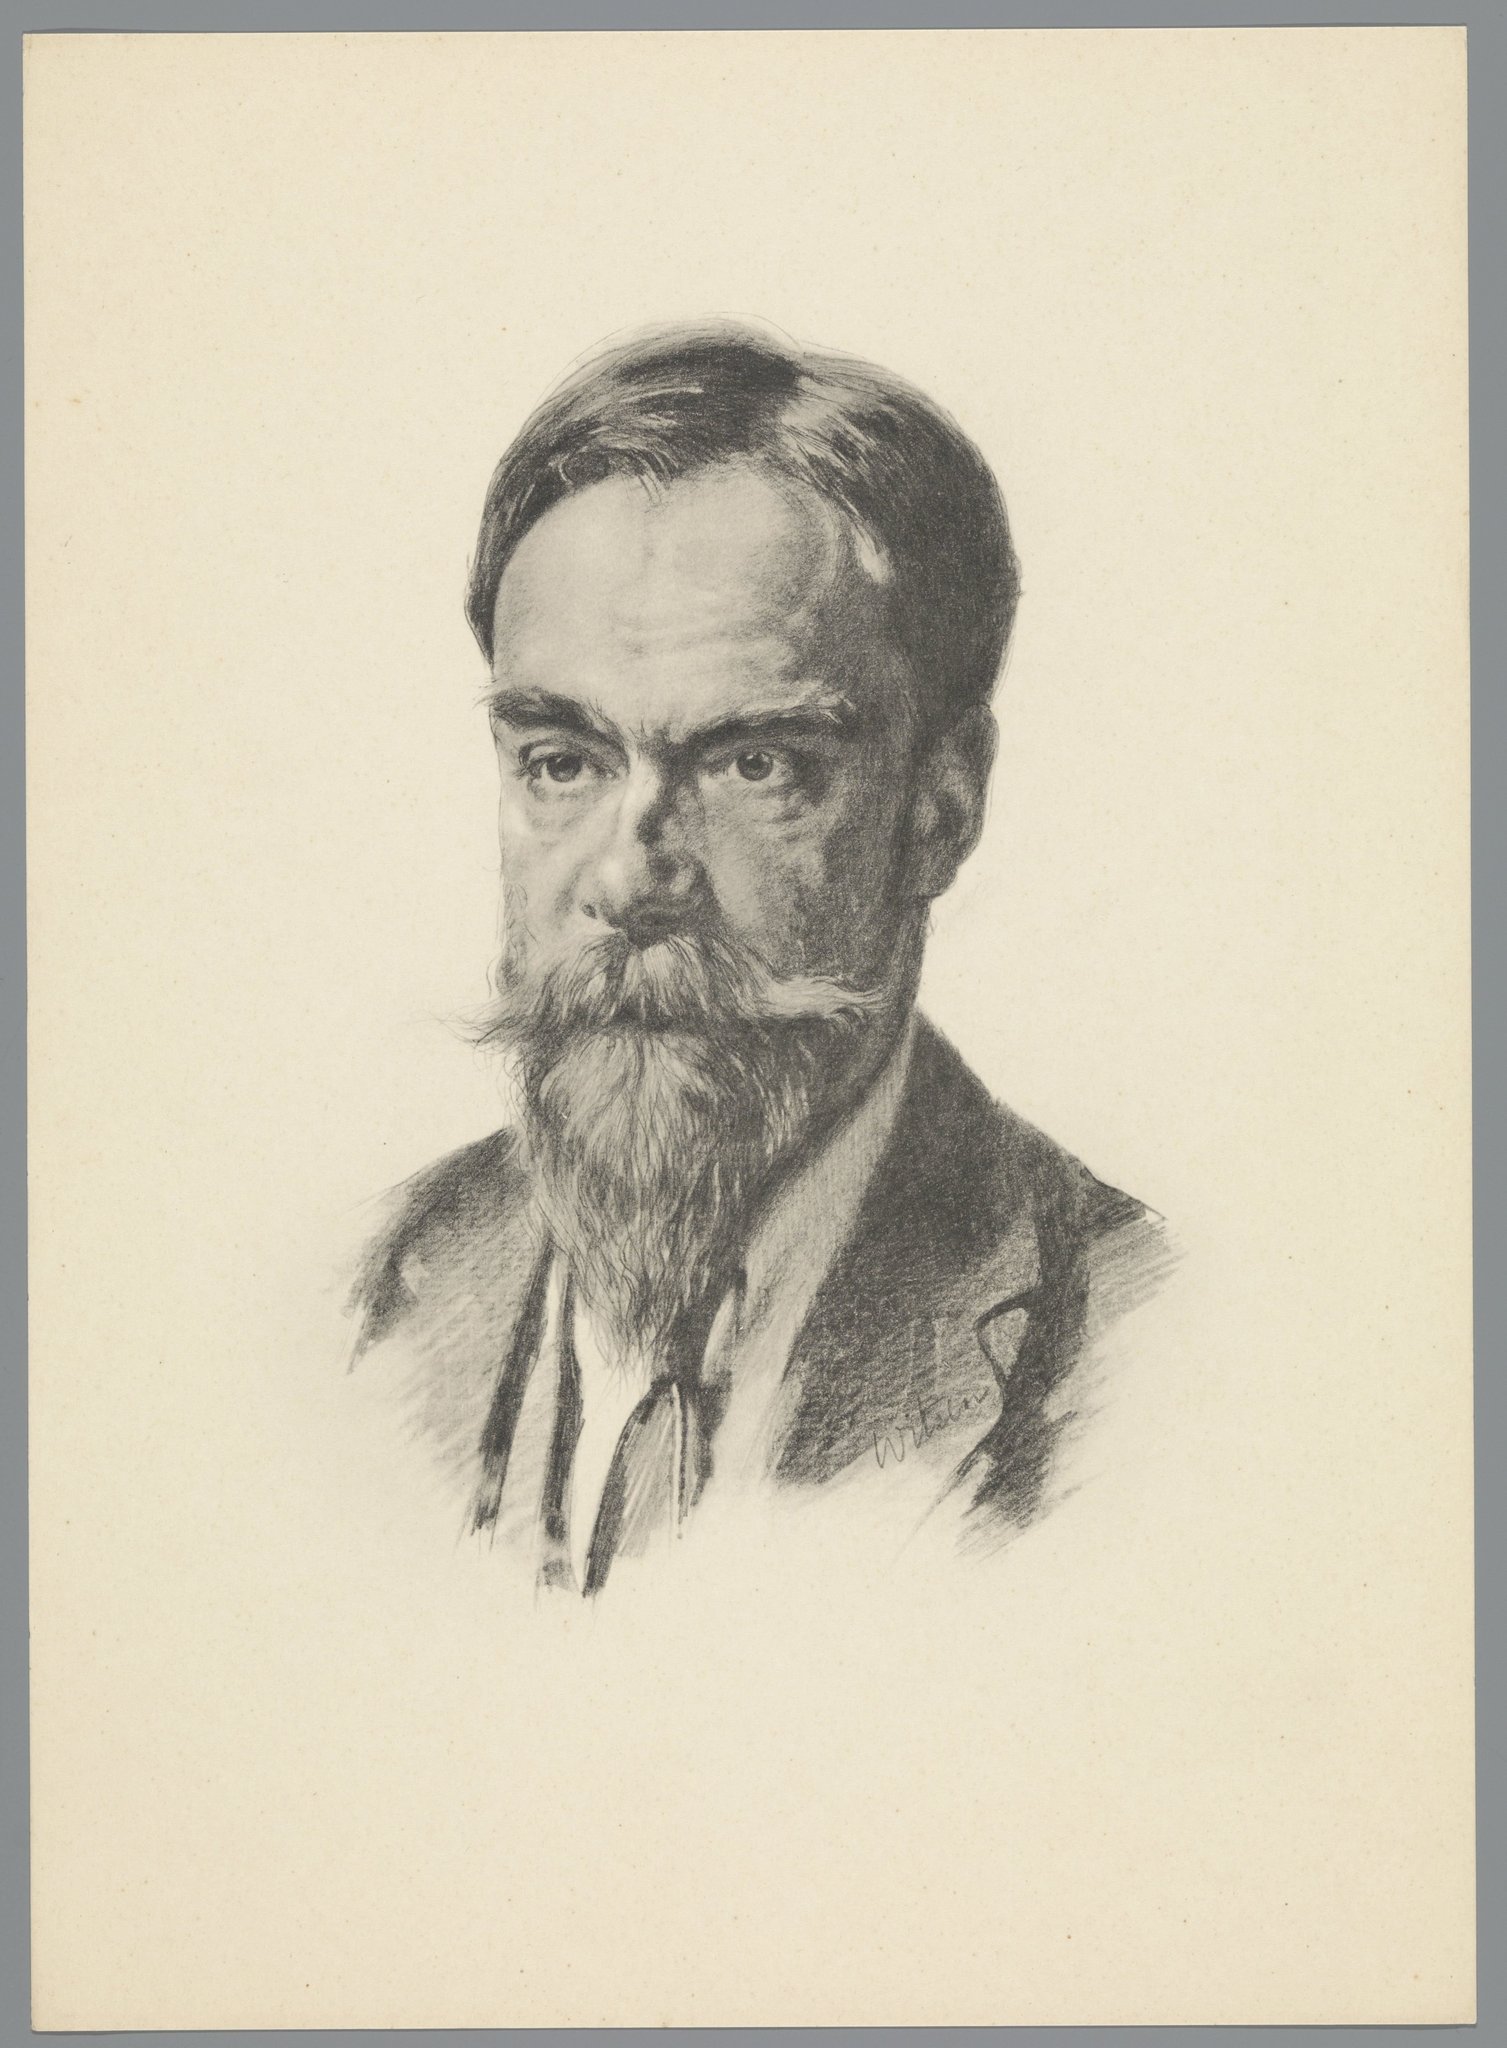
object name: print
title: Reproductie naar krijttekening met portret van Frans Coenen Jr.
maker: Anonymous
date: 1860-1915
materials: paper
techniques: photograph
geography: netherlands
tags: frans coenen (1866-1936)